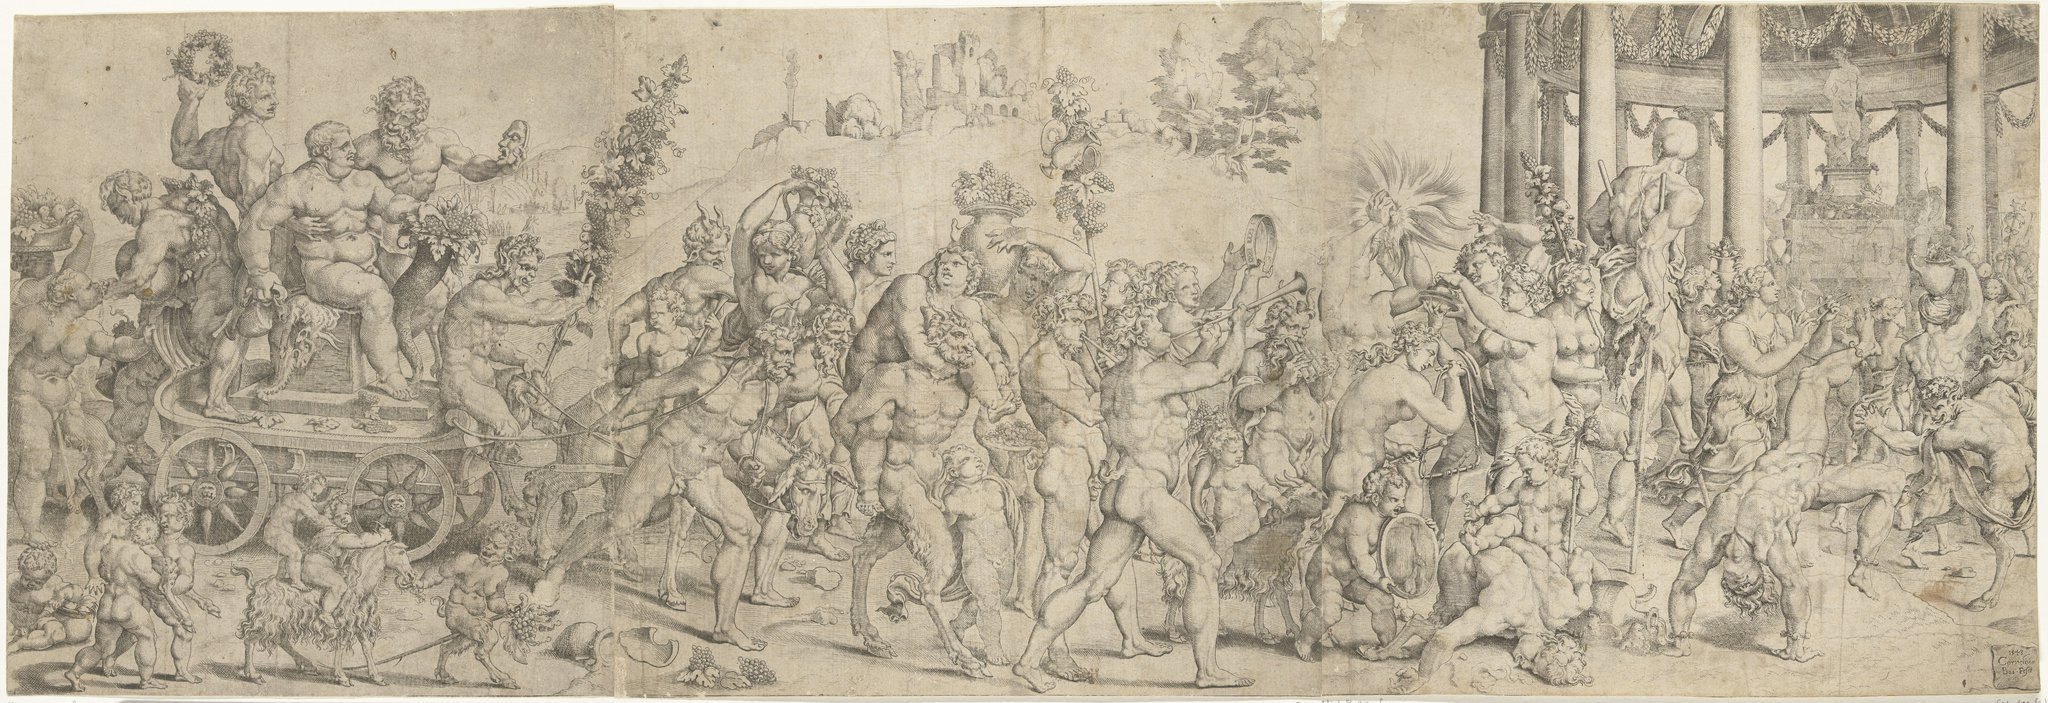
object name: print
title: Triomf van Bacchus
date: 1543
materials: paper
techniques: engraving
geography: antwerp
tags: triumph of bacchus; 'carro di bacco' (ripa)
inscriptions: collector's mark: ‘Hinloopen’, collector's mark: Lugt 11, collector's mark: Lugt 10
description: Prent bestaande uit drie platen. Optocht ter ere van de God Bacchus. Op een triomfwagen zit Bacchus. In de stoet die met de wagen naar een tempel loopt zijn saters putti en anderen uitgelaten aan het feesten en dansen. Sommigen spelen op fluit of tamboerijn, anderen dragen stokken of kruiken met druiventrossen en wijnranken met zich mee.